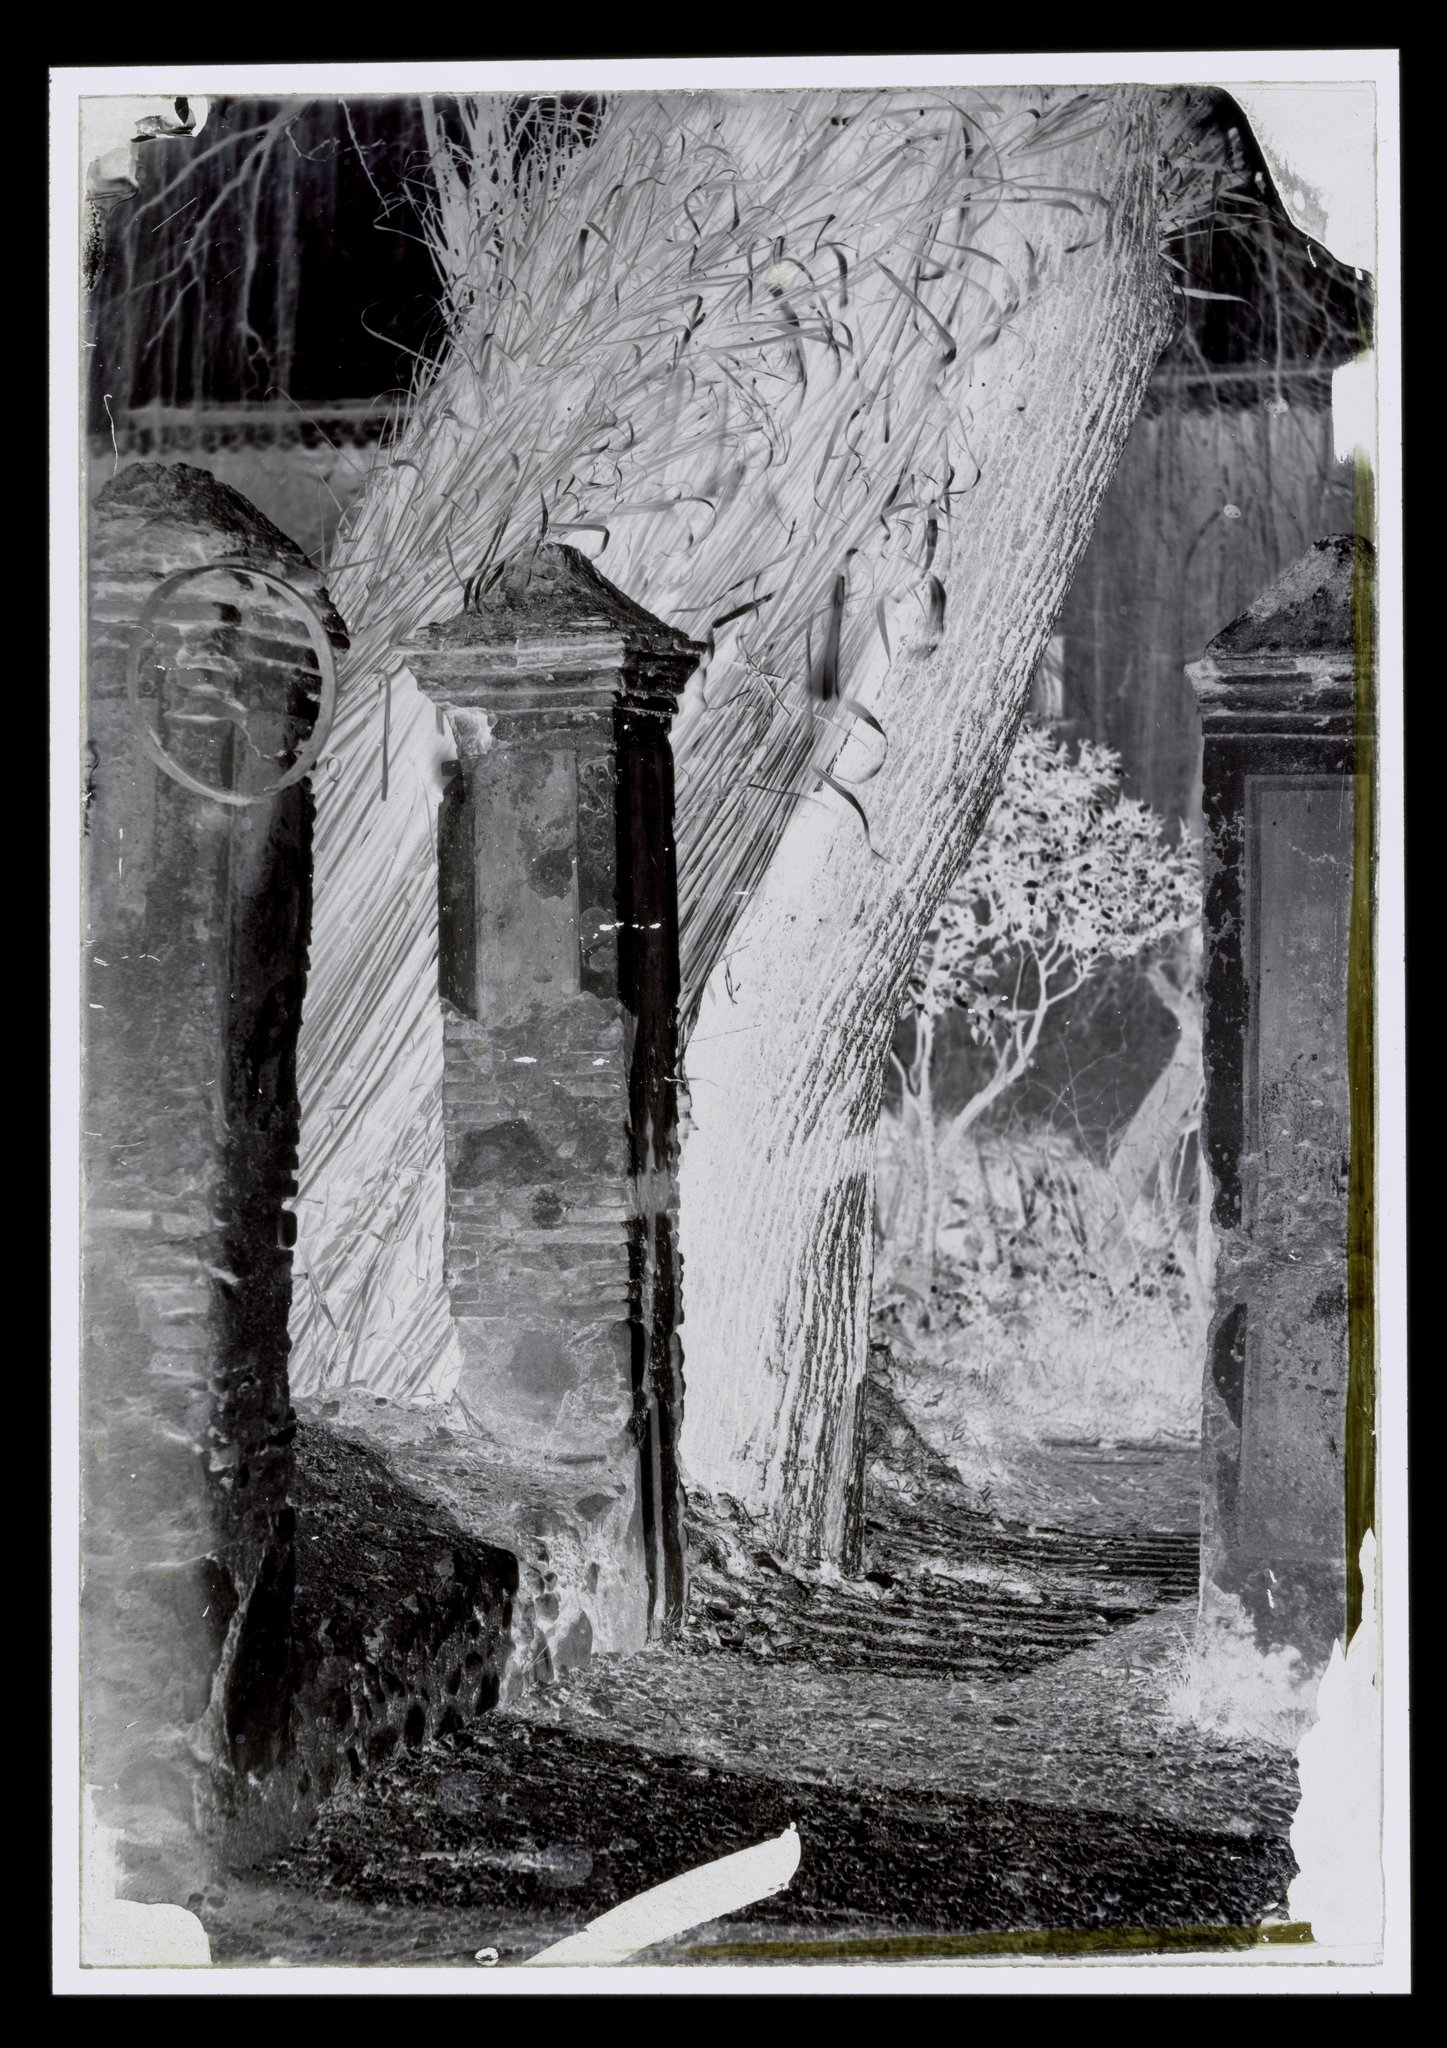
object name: glasnegatief, glasplaatnegatief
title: Gezicht in een tuin, vermoedelijk in Rome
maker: laurens lodewijk kleijn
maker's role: draughtsman, painter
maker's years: 1826-1909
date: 1851-1868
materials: glass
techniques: collodion process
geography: rome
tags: garden, rome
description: Onderdeel van een groep glasnegatieven uit de nalatenschap van de schilder Laurens Lodewijk Kleijn, met stillevens, portretten, zelfportretten en kunstreproducties.